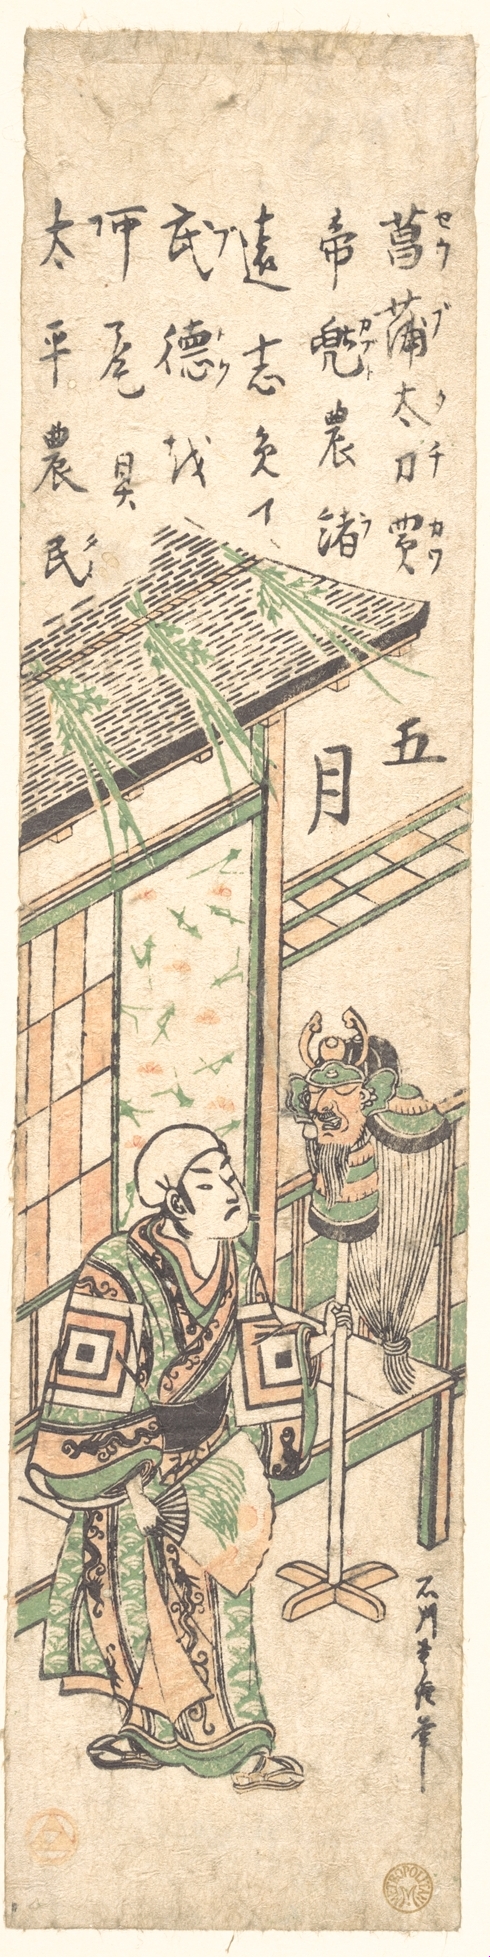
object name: print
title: The Fifth Month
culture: japanese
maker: ishikawa toyonobu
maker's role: artist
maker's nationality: japanese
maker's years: 1711-1785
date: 1748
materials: ink, paper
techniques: woodblock print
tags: helmets,men